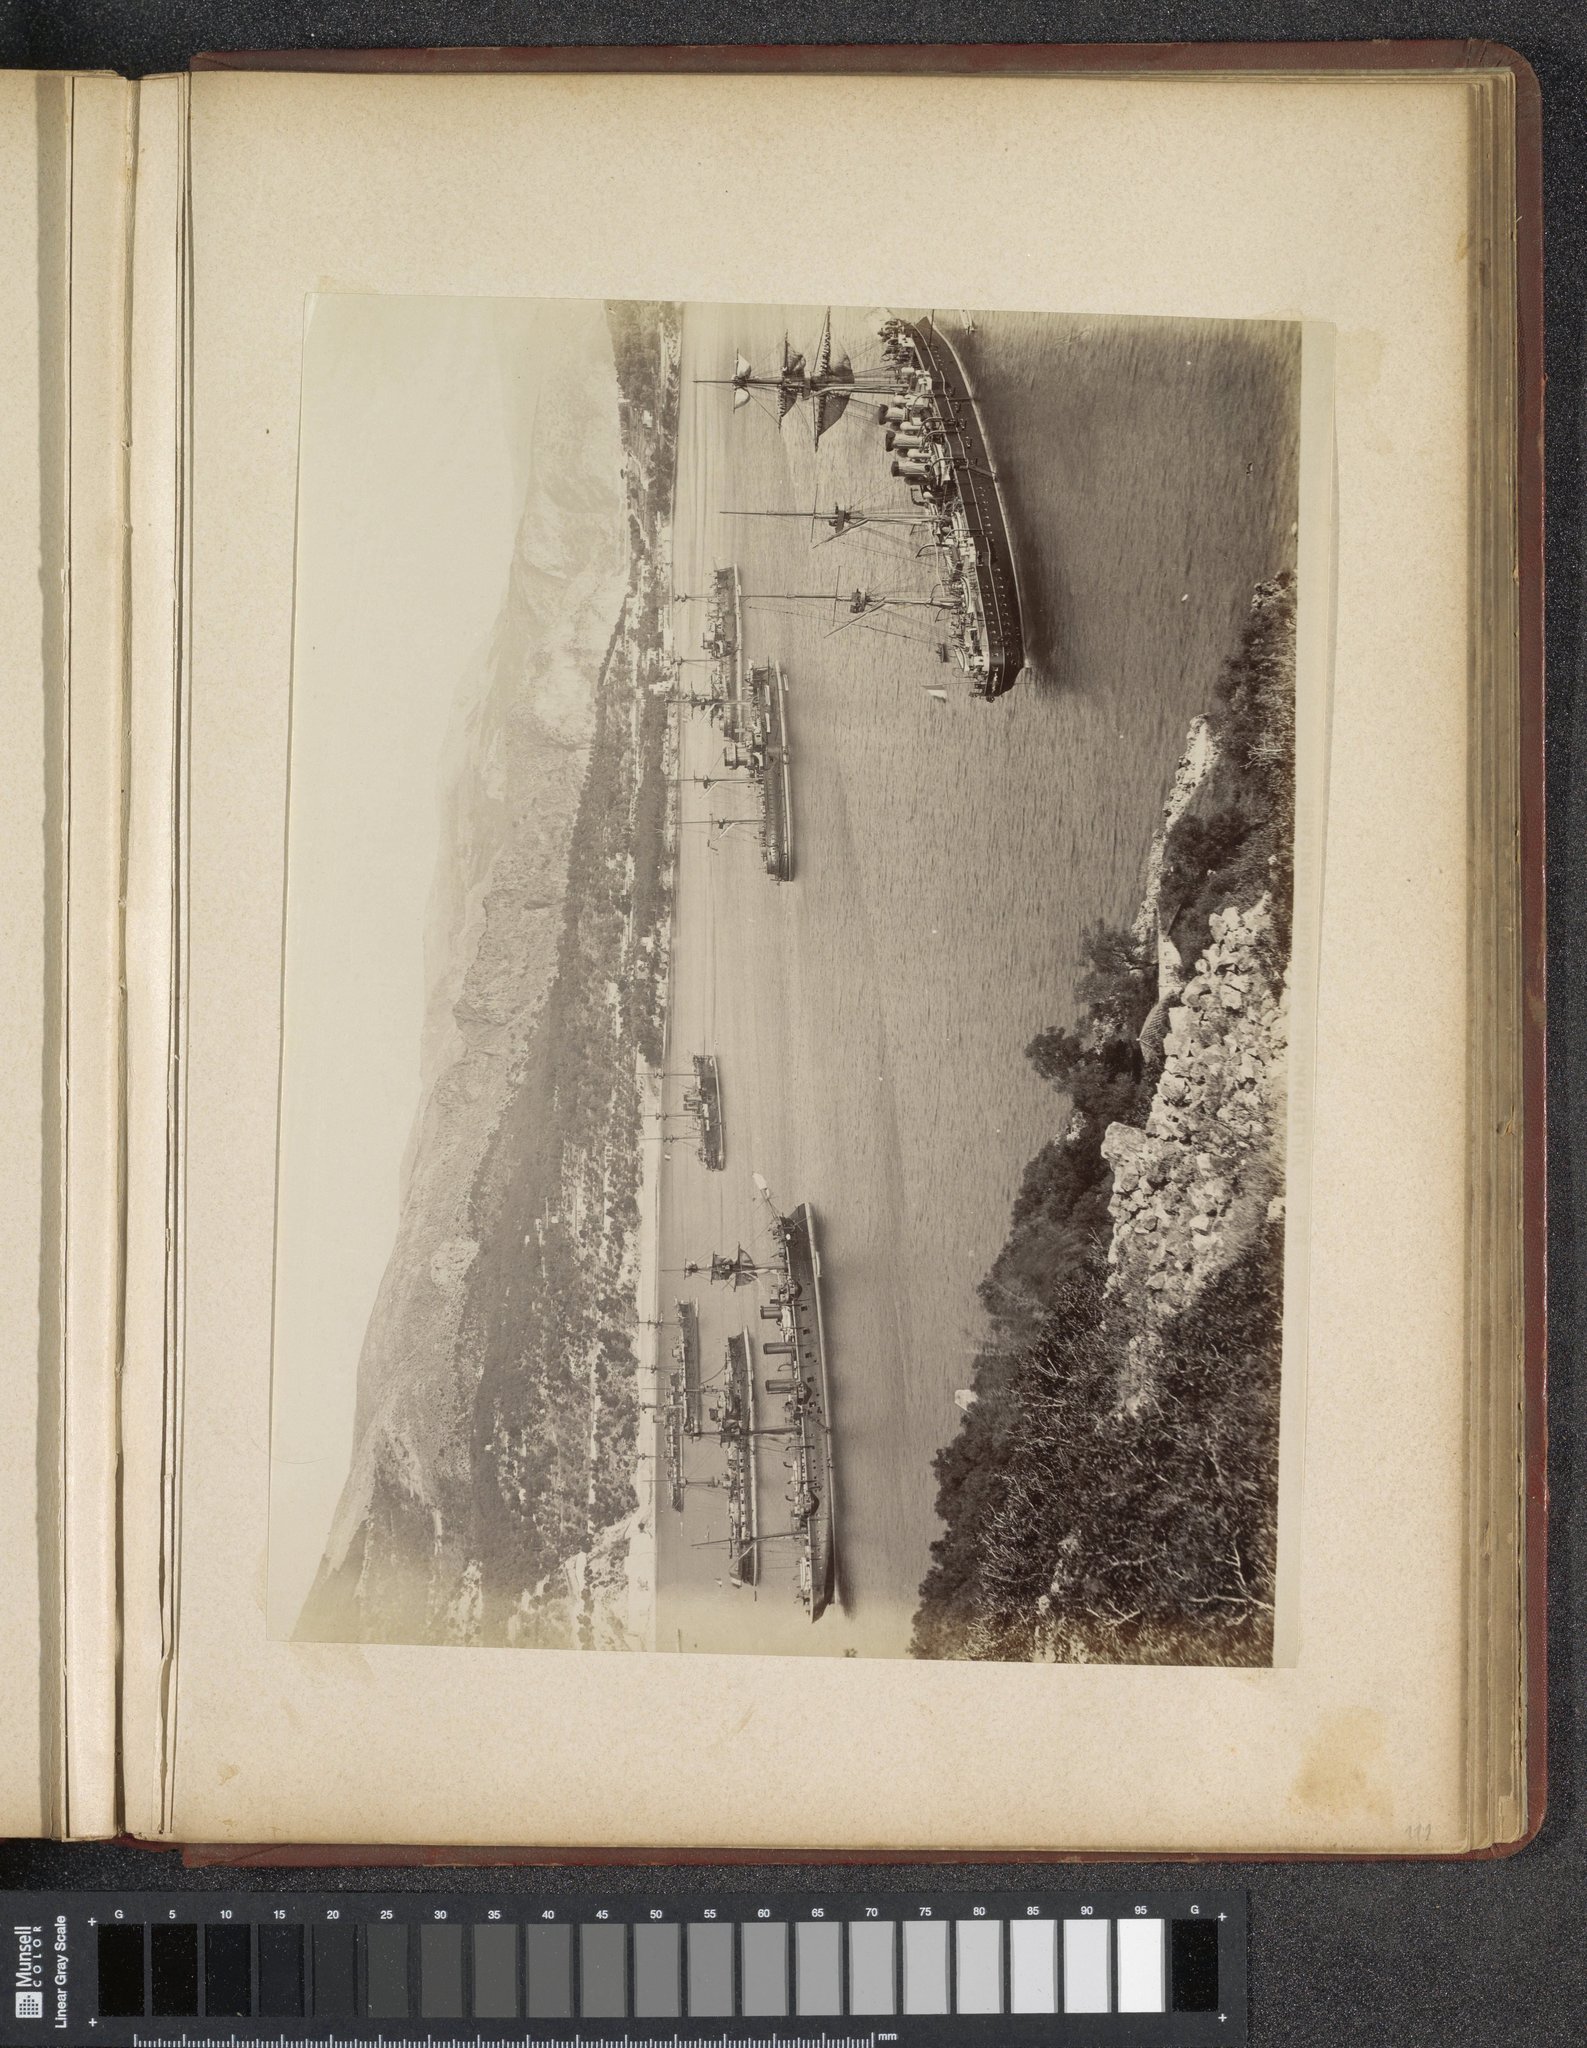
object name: photograph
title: Vlooteskader op de rede van Villefranche-sur-Mer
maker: jean gilletta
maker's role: fotograaf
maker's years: 1856-1933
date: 1870-1900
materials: paper, photographic support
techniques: albumen print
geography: villefranche-sur-mer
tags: gulf, bay (+ landscape with figures, staffage), sailing-ship, sailing-boat (with name), ship in the roads, roadstead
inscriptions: negative number: ‘353’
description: Onderdeel van Reisalbum met foto's van bezienswaardigheden in Italië en Zuid-Frankrijk.